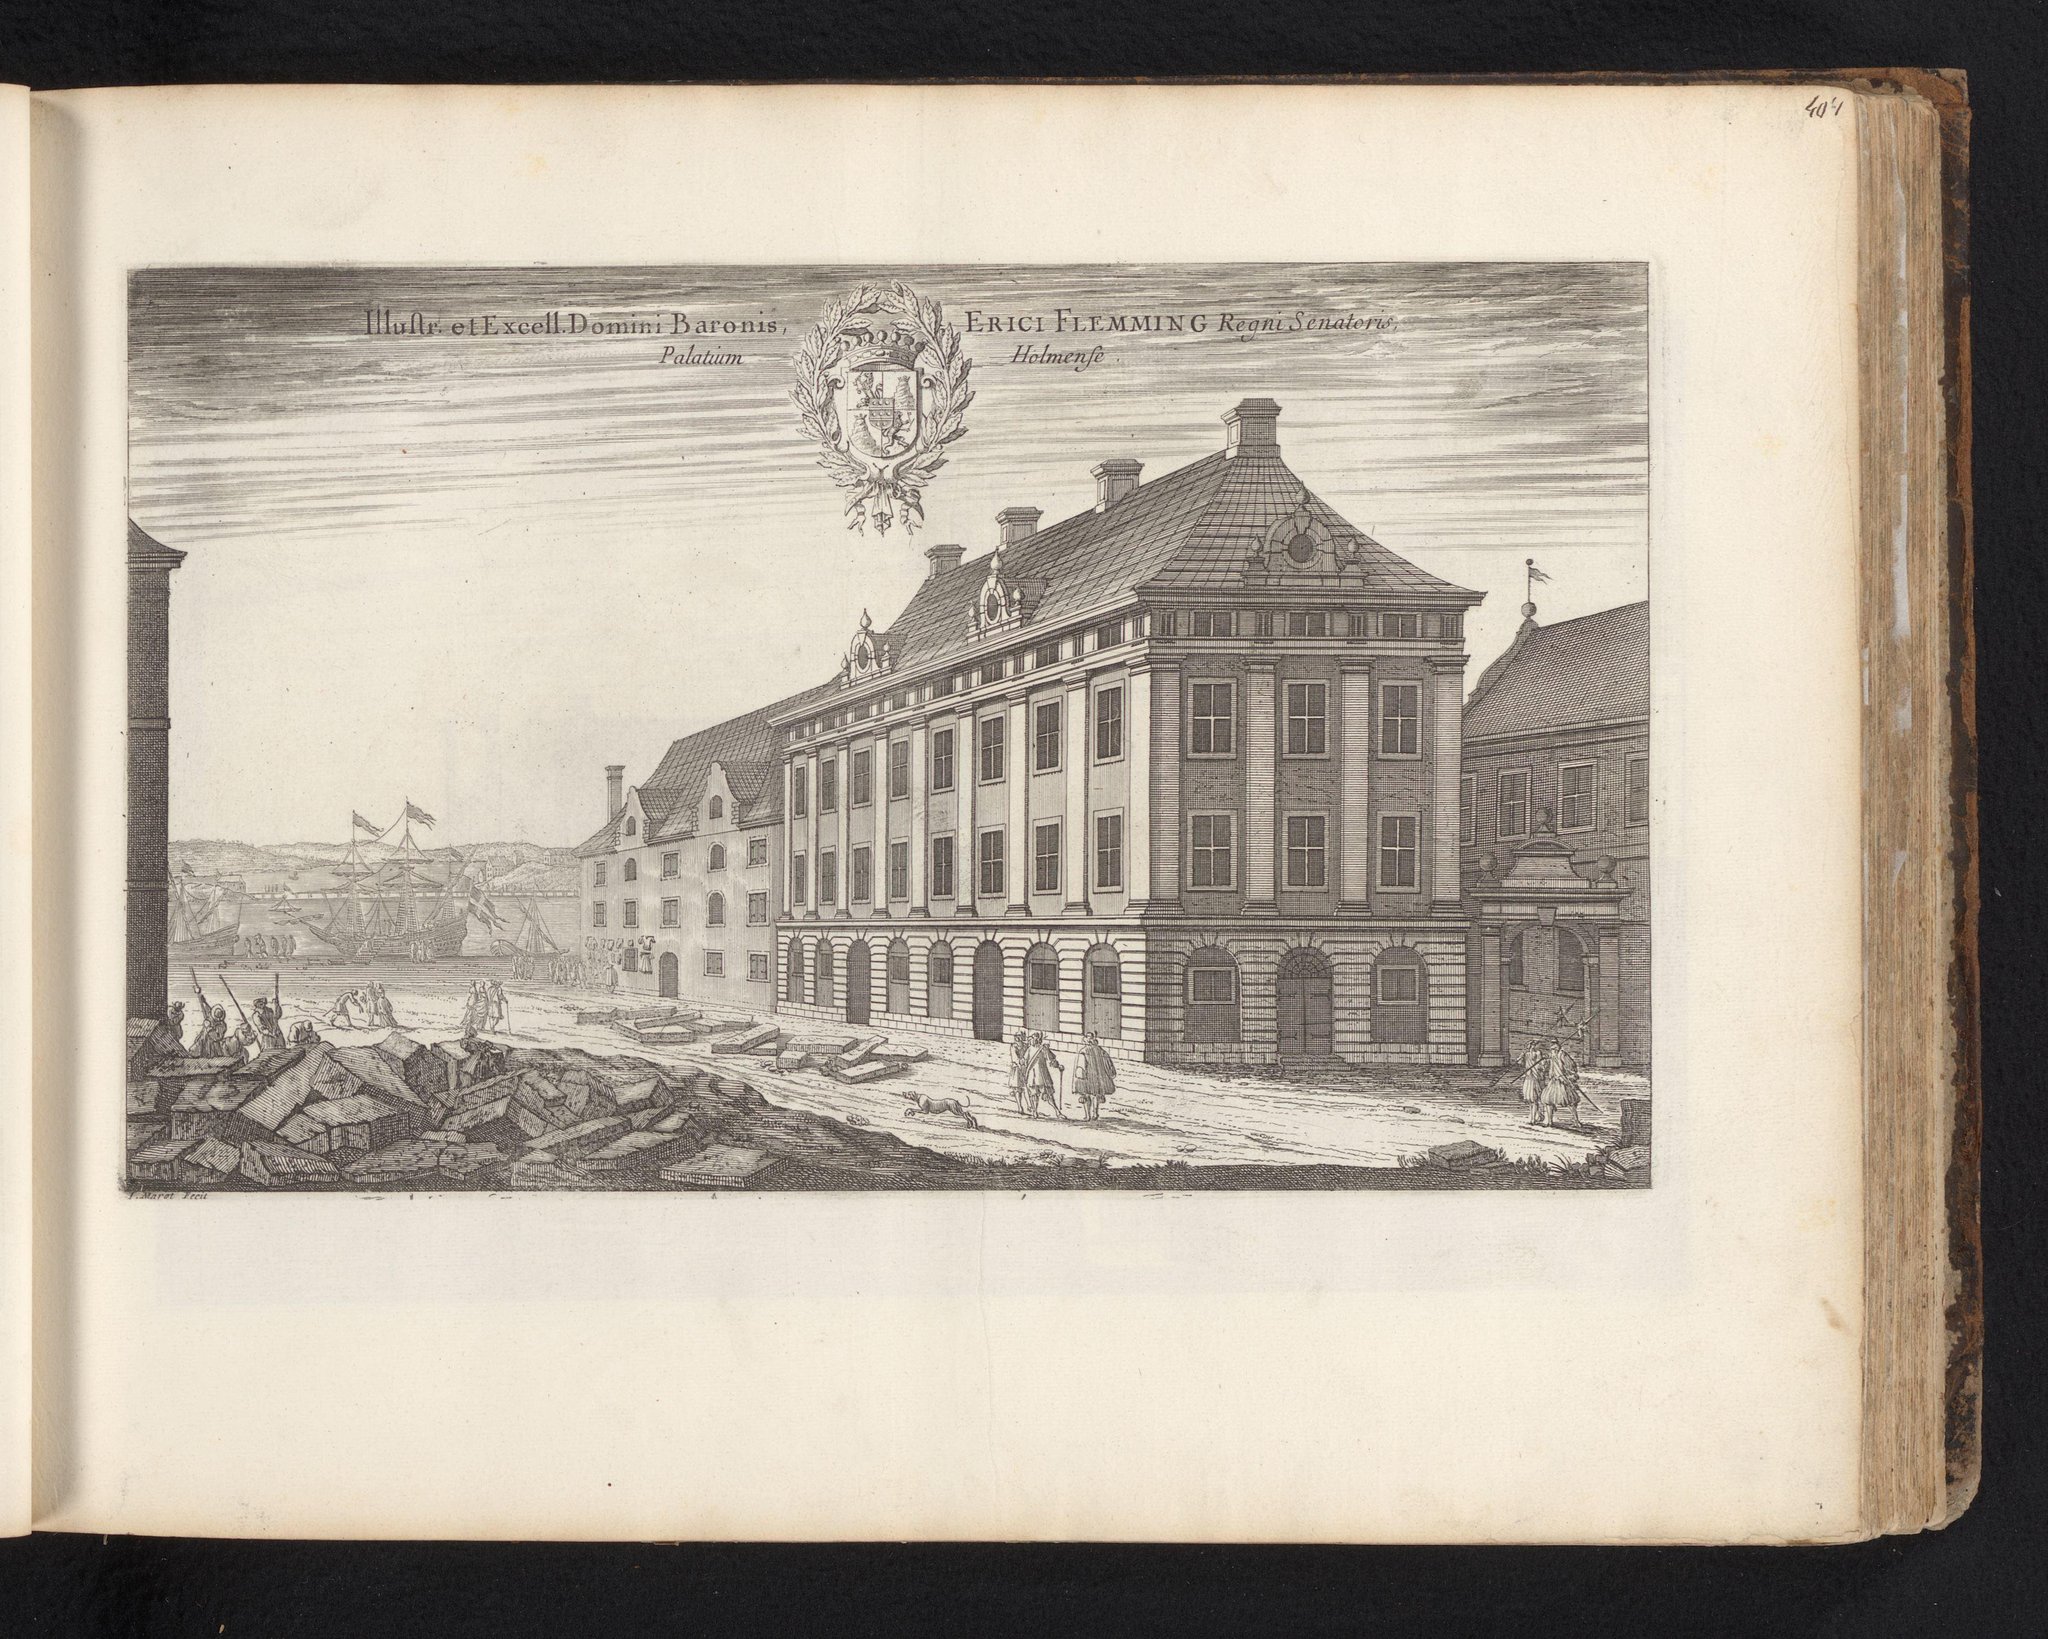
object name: print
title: Illustr. et Excell. Domini Baronis Erici Flemming Regni Senatoris Palatium Holmense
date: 1670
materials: paper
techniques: etching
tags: palace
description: Kungliga Biblioteket, 'Suecia': http://www.kb.se/samlingarna/Kartor-bilder/Suecia-antiqua/ (geraadpleegd november 2016).